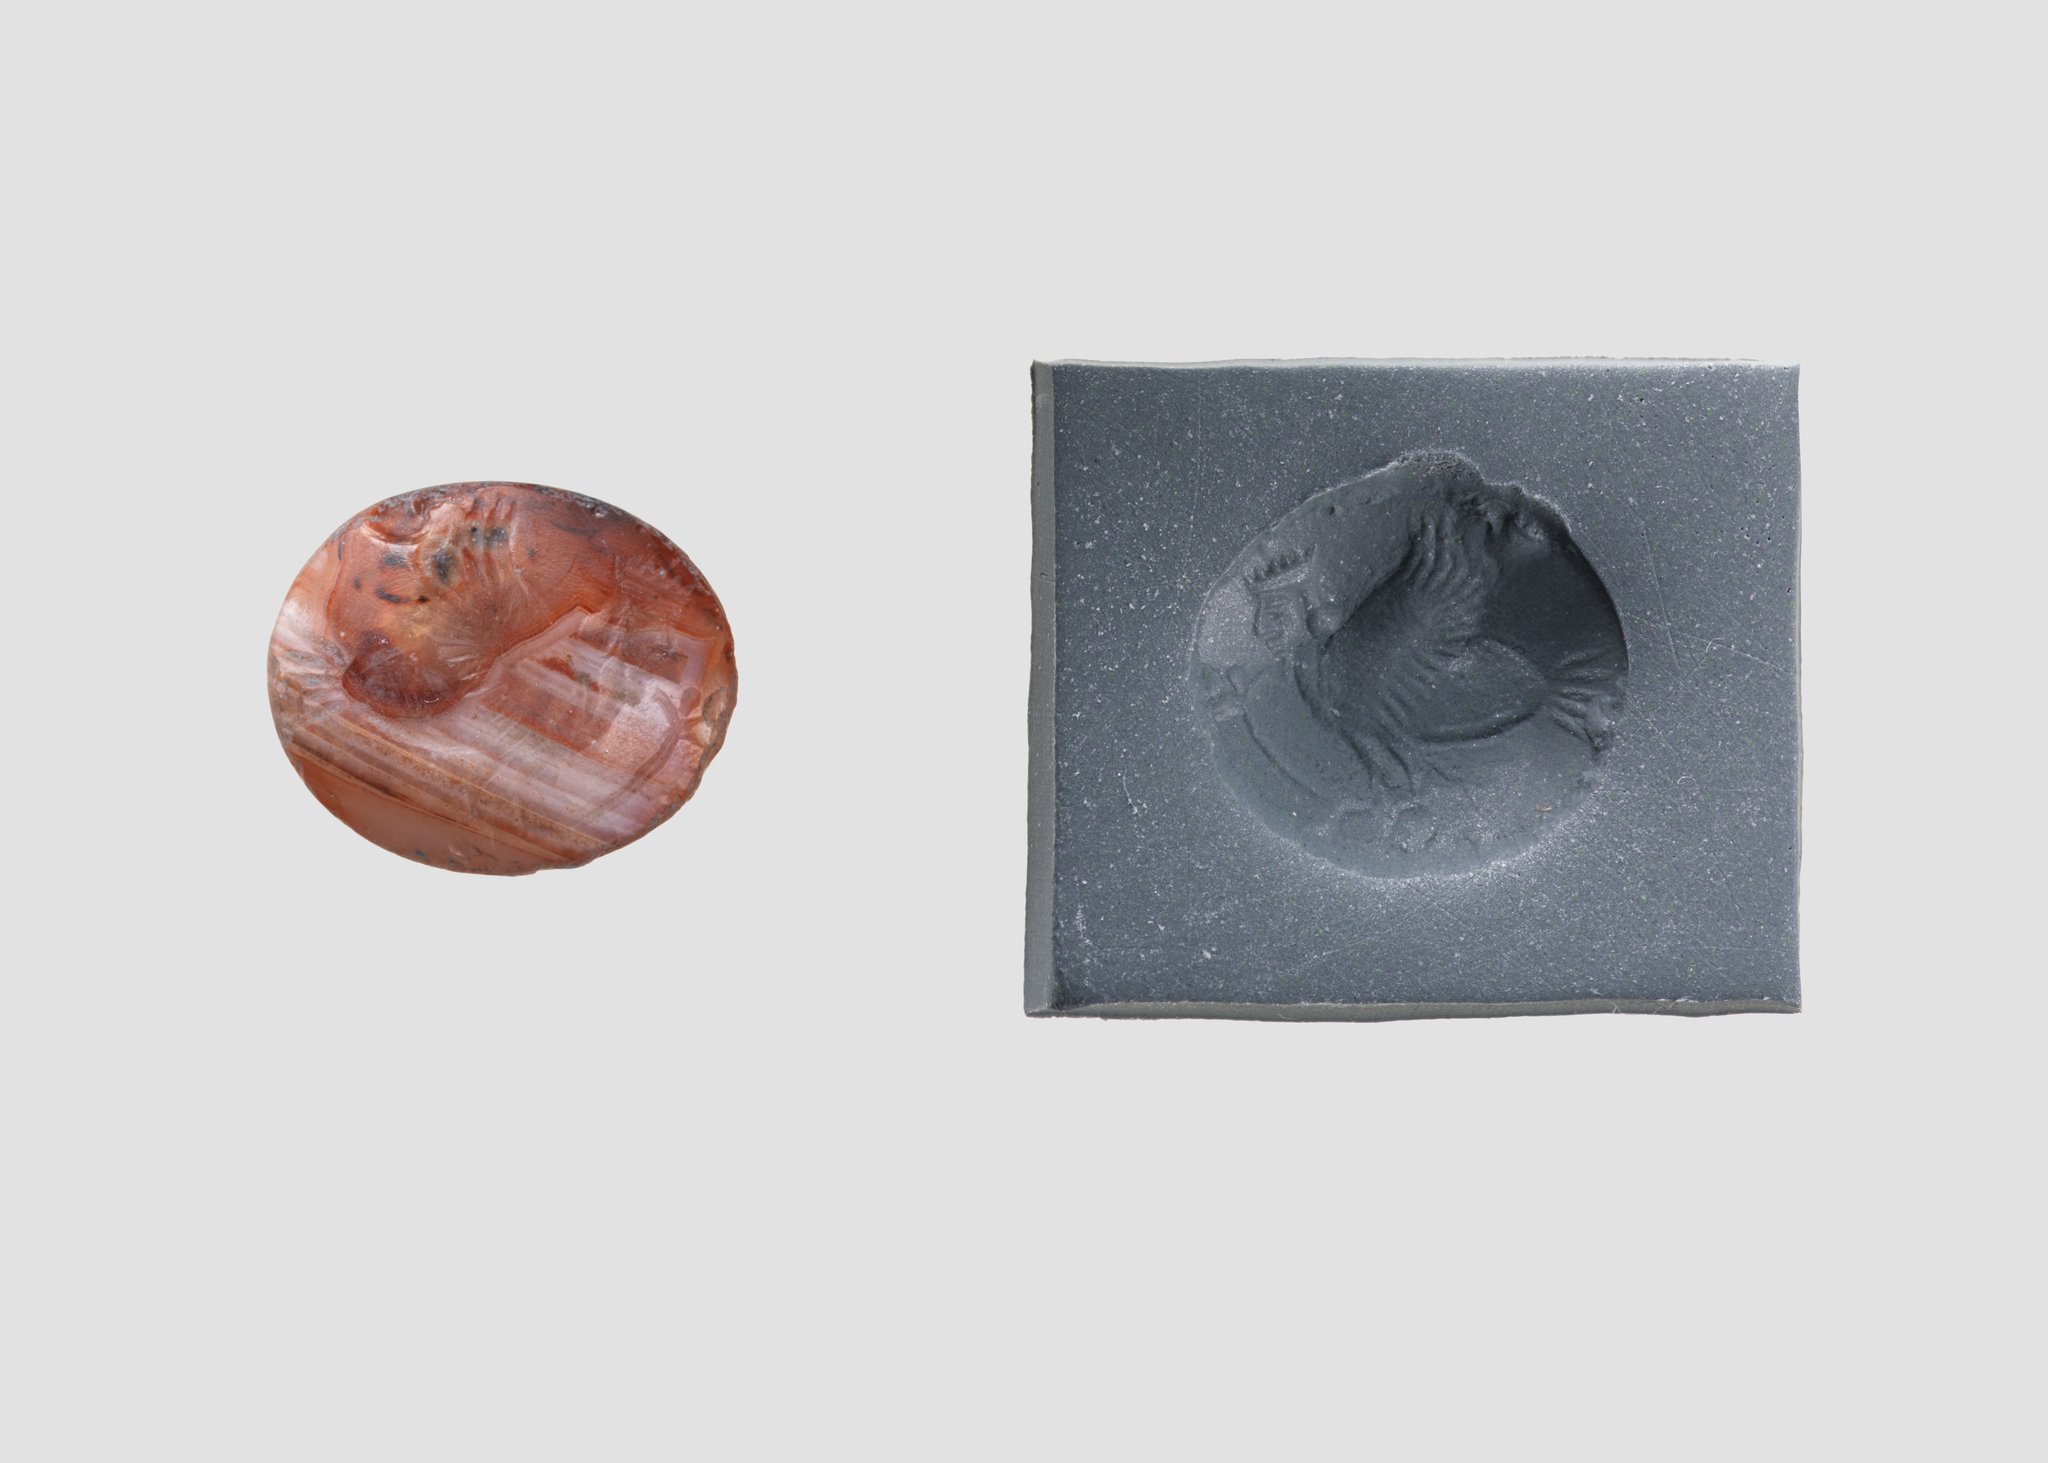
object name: stamp seal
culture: achaemenid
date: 600-301 BCE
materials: stone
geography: iran